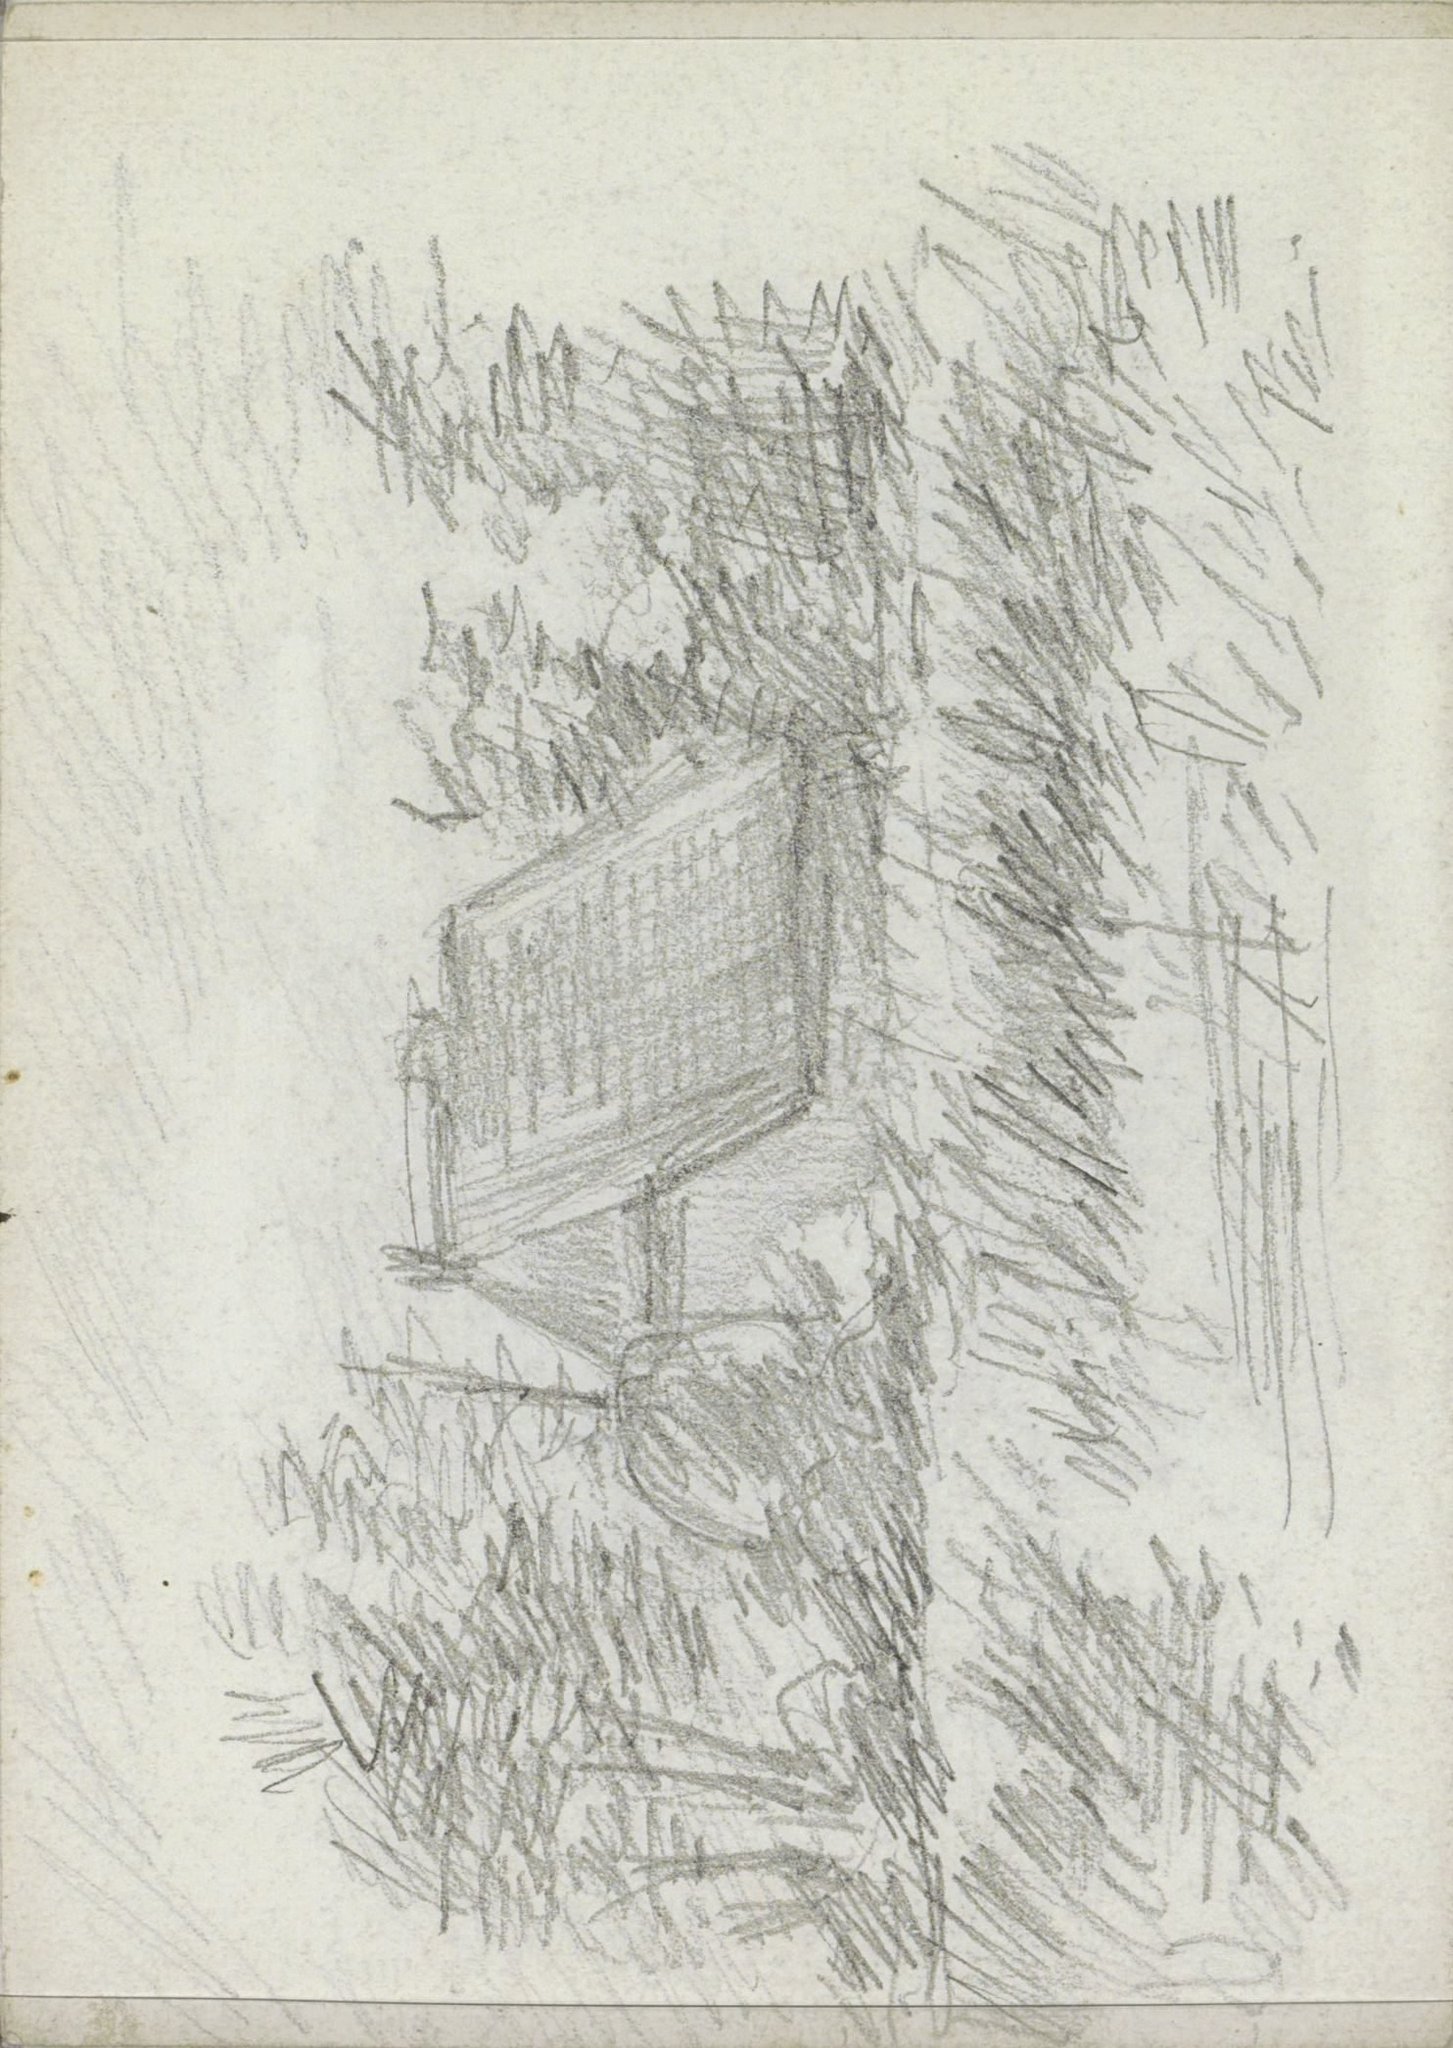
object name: sketchbook leaf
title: Huis tussen de bomen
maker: jozef israëls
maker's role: draughtsman, painter, print maker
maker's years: 1824-1911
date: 1834-1911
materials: paper, pencil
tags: farm or solitary house in landscape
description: Blad 7 verso uit een omslag van een schetsboek met 7 losse bladen.